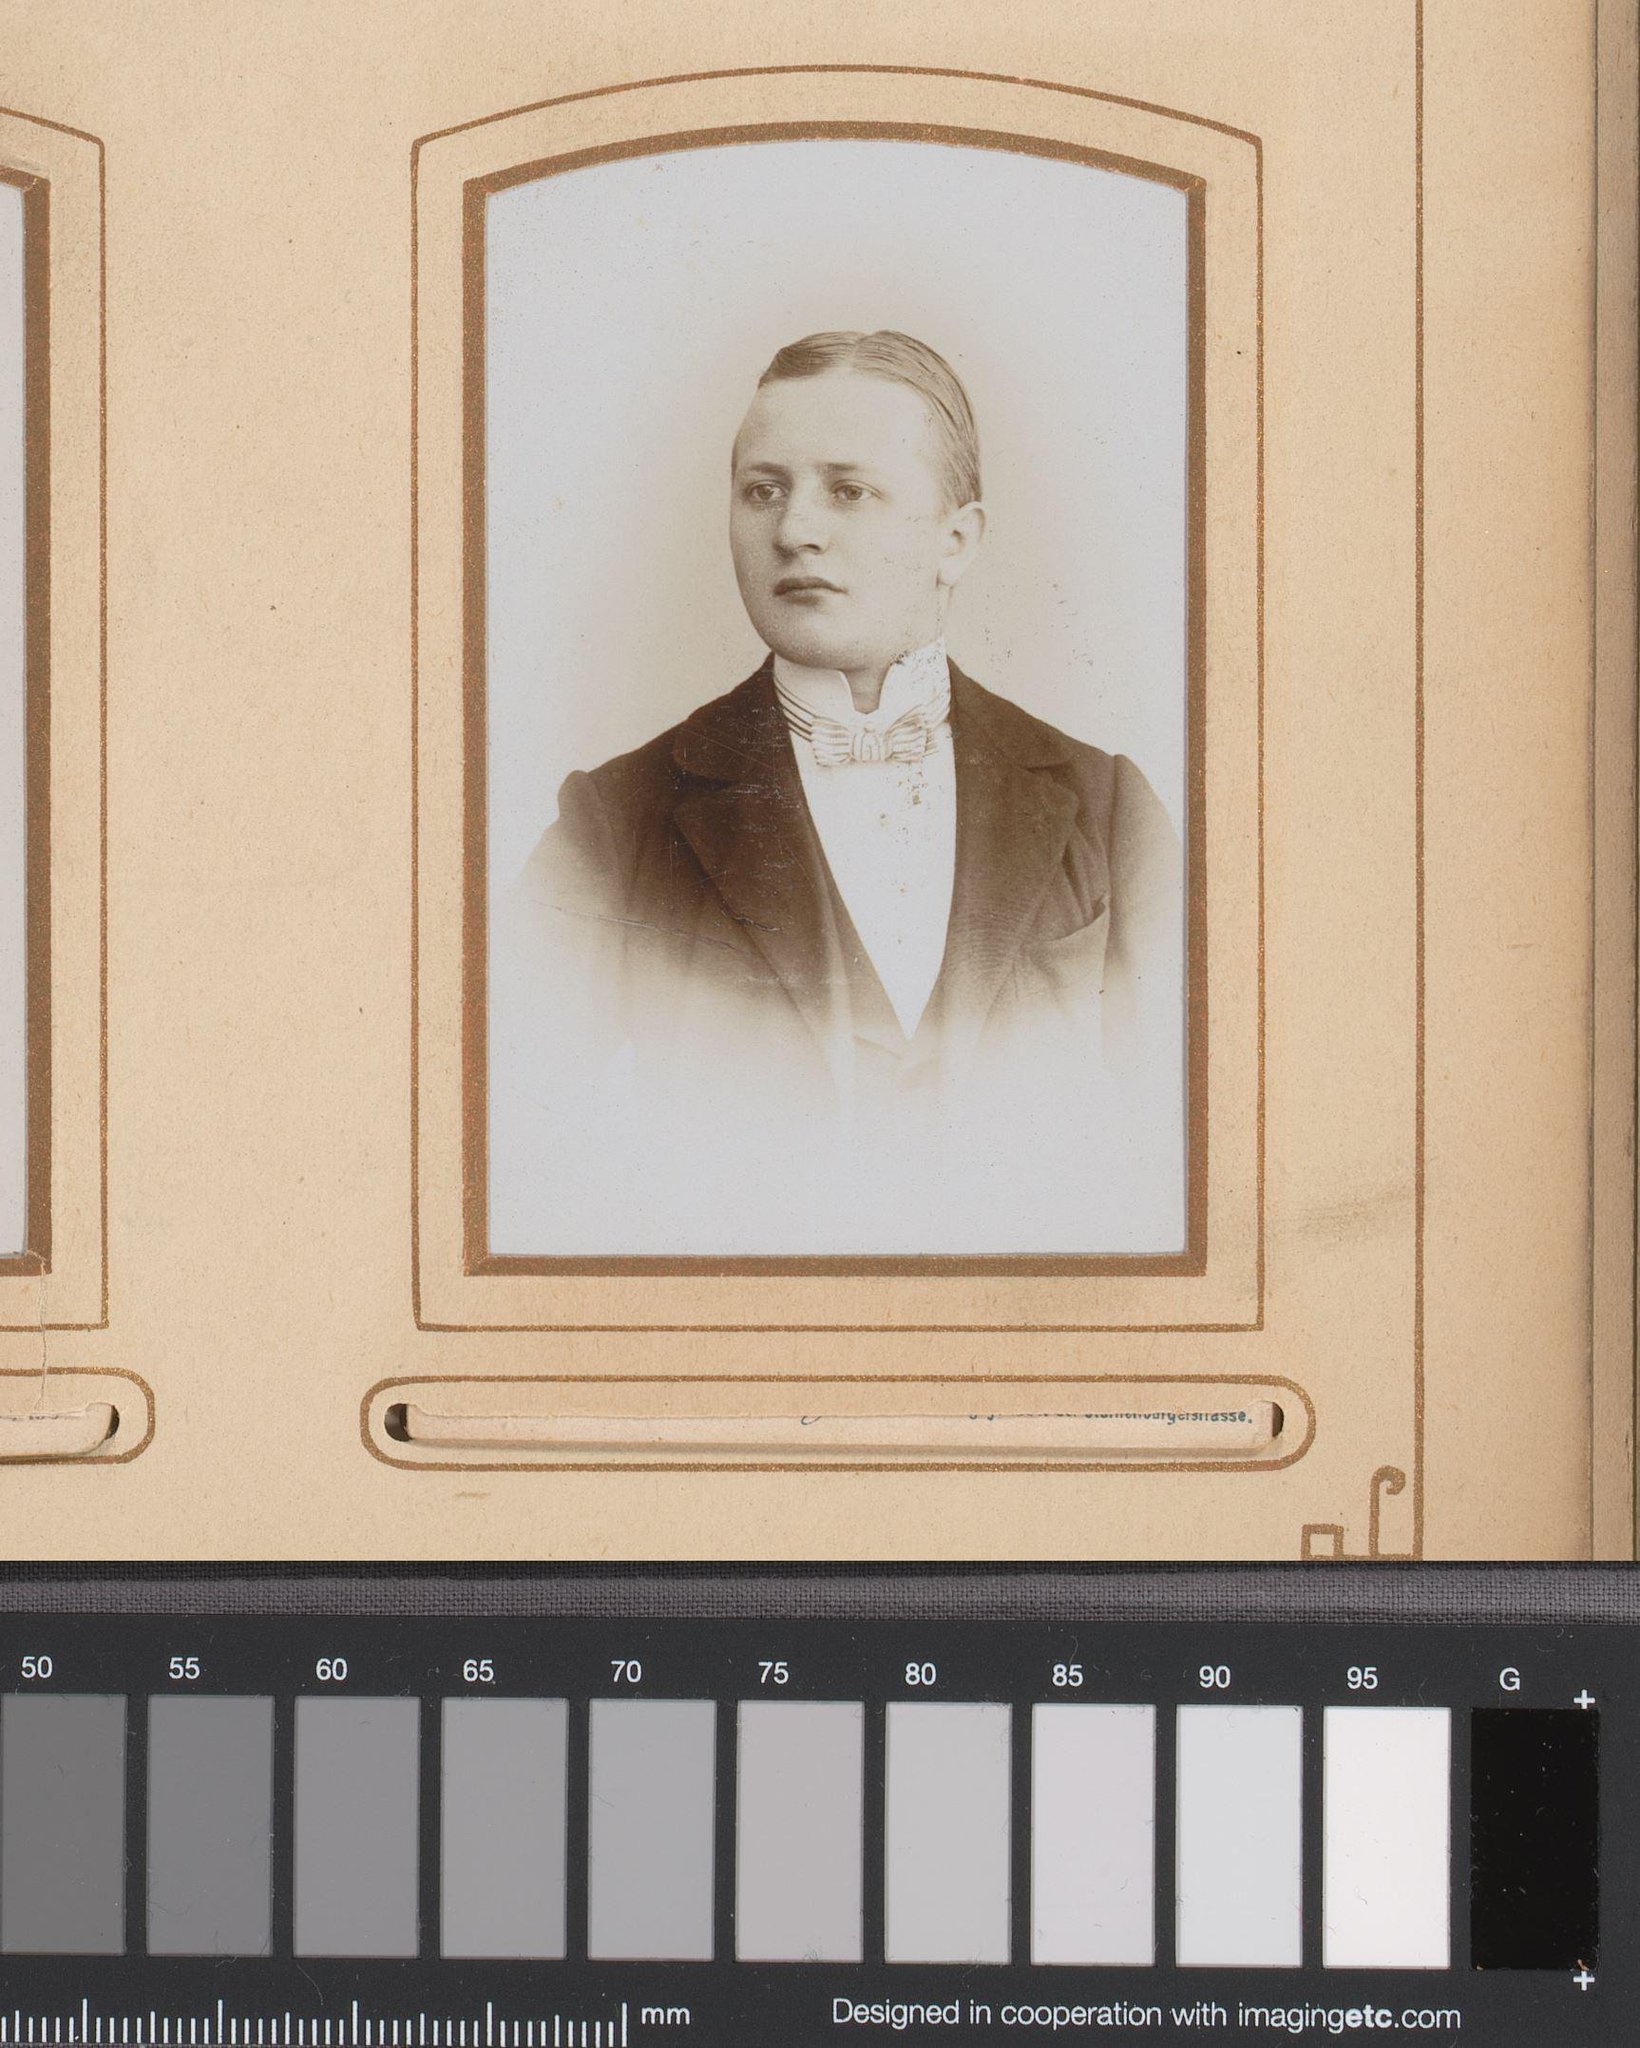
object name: photograph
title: Portret van een jongeman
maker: max piepenhagen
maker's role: fotograaf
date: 1903-1912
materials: cardboard, photographic support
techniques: collodion silver print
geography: berlin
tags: historical persons, youth, adolescent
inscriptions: inscription: ‘Max Piepenhagen/ Berlin, N./ Friedrichstrasse 122/123/ gegenüber der Oranienburgstrasse’